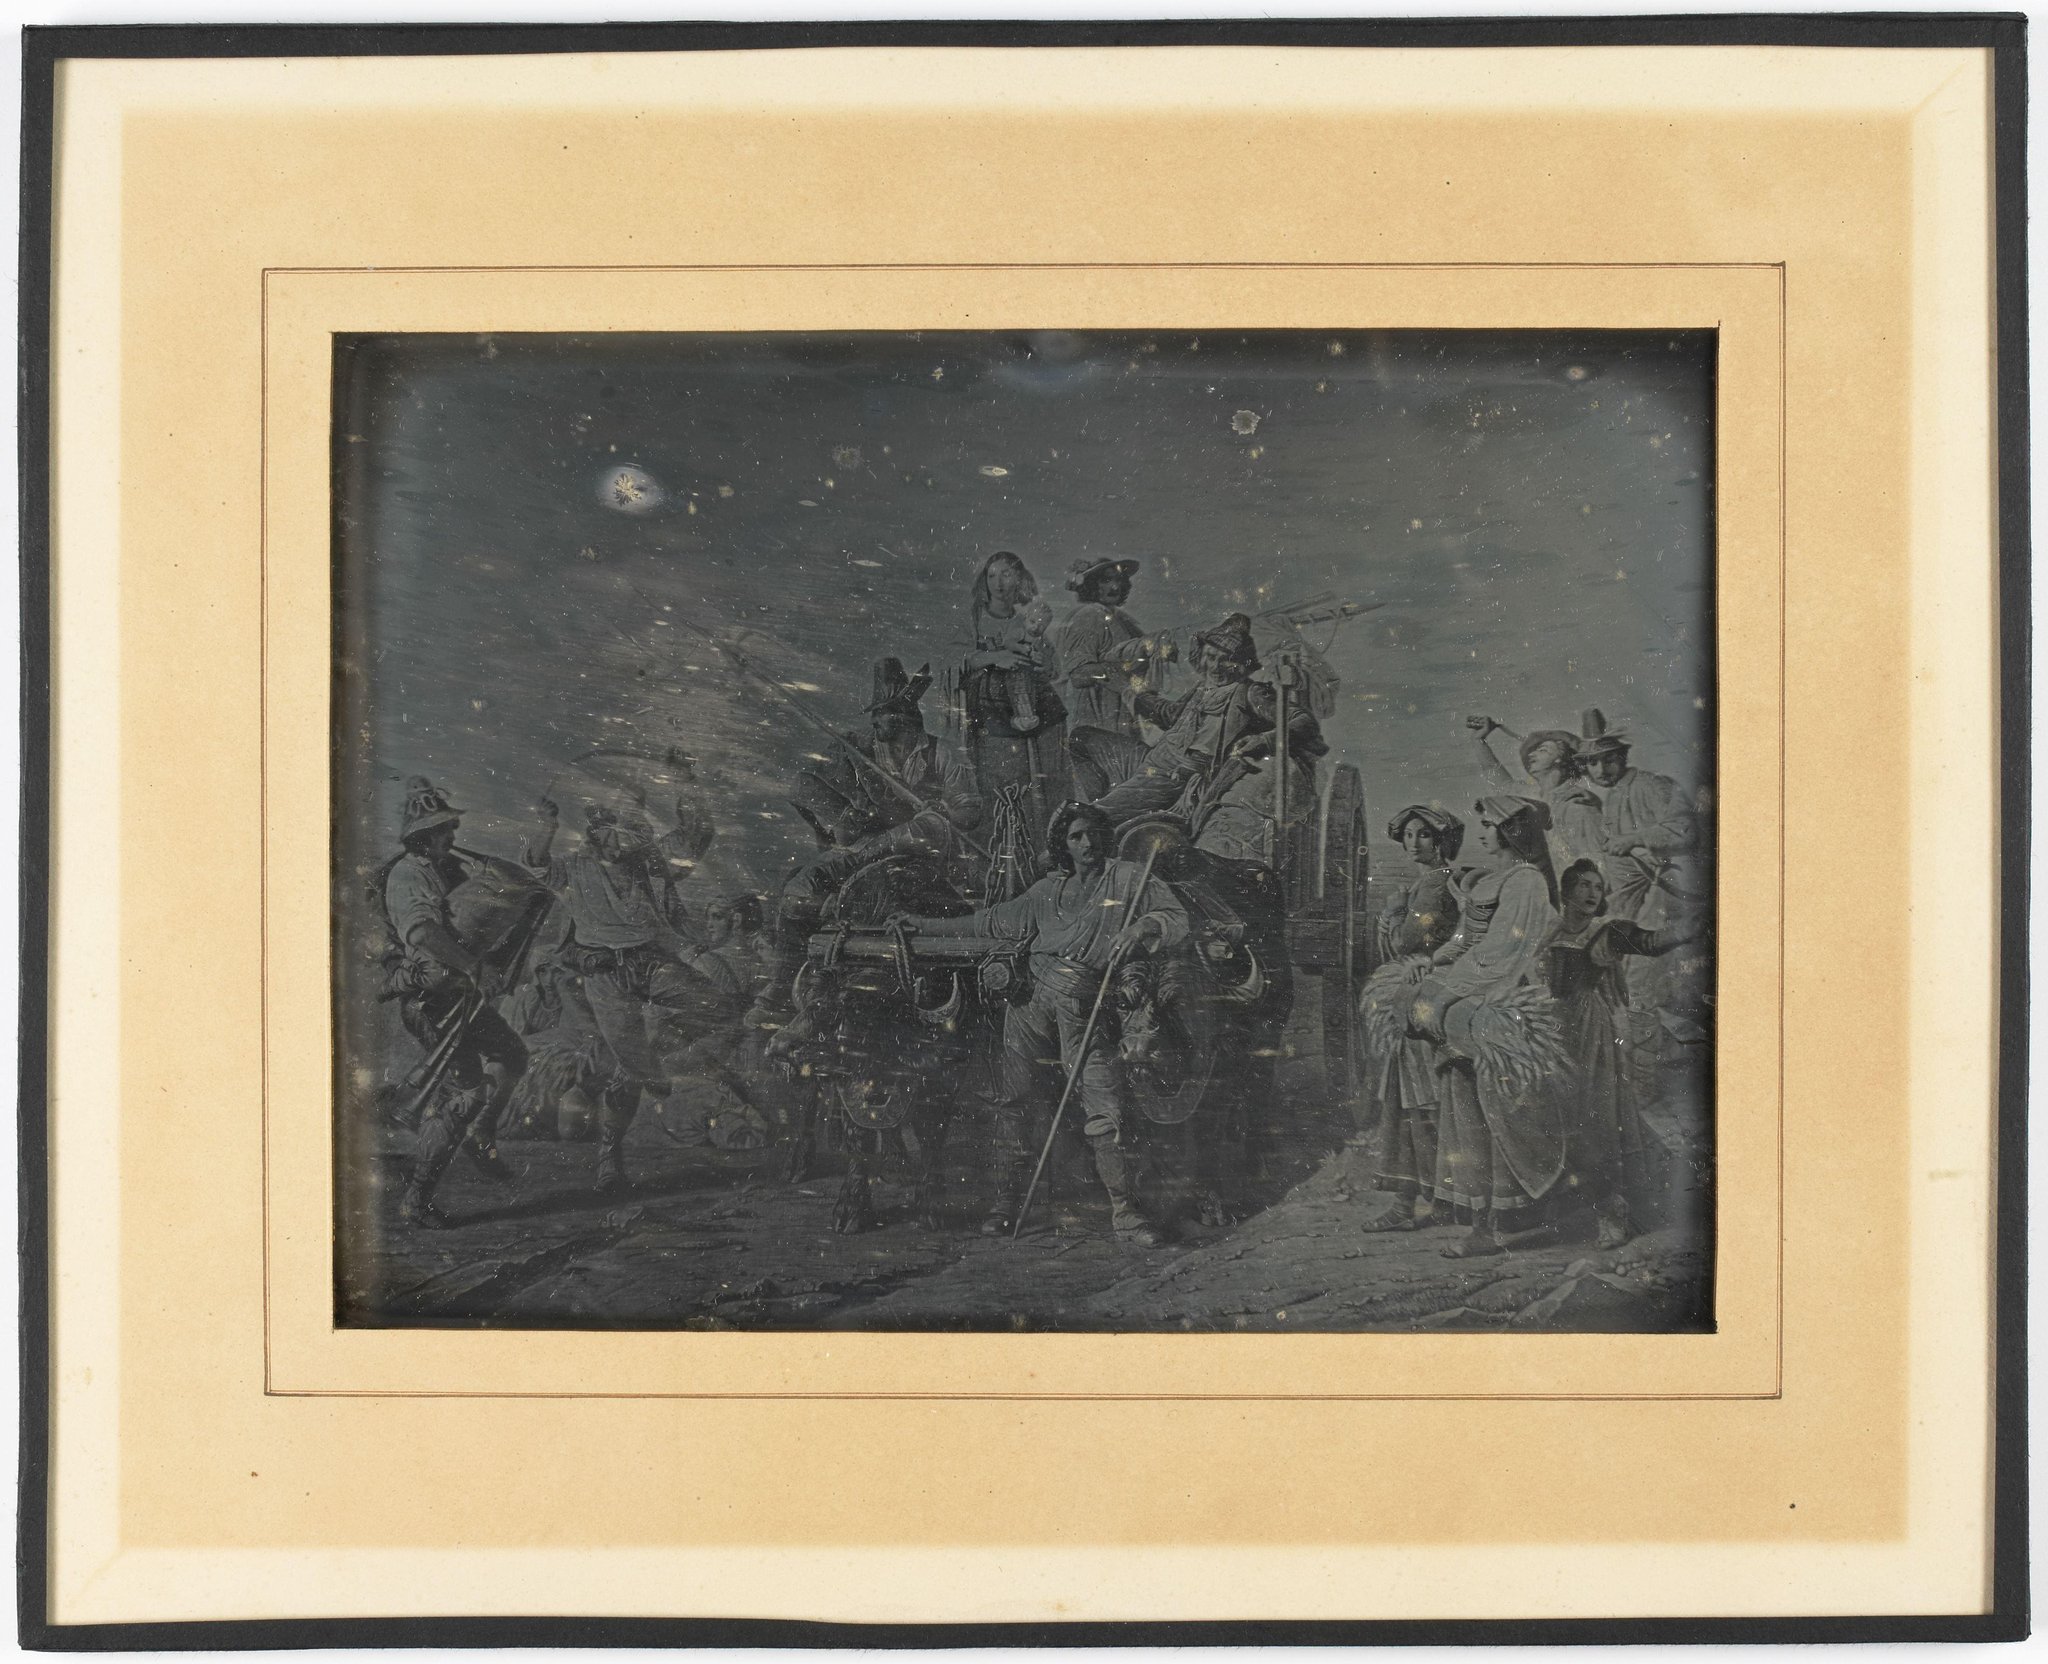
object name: reproduction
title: Daguerreotypie naar schilderij/prent L. Robert Rome 1830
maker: vincent chevallier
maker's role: fotograaf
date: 1839-1841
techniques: daguerreotype